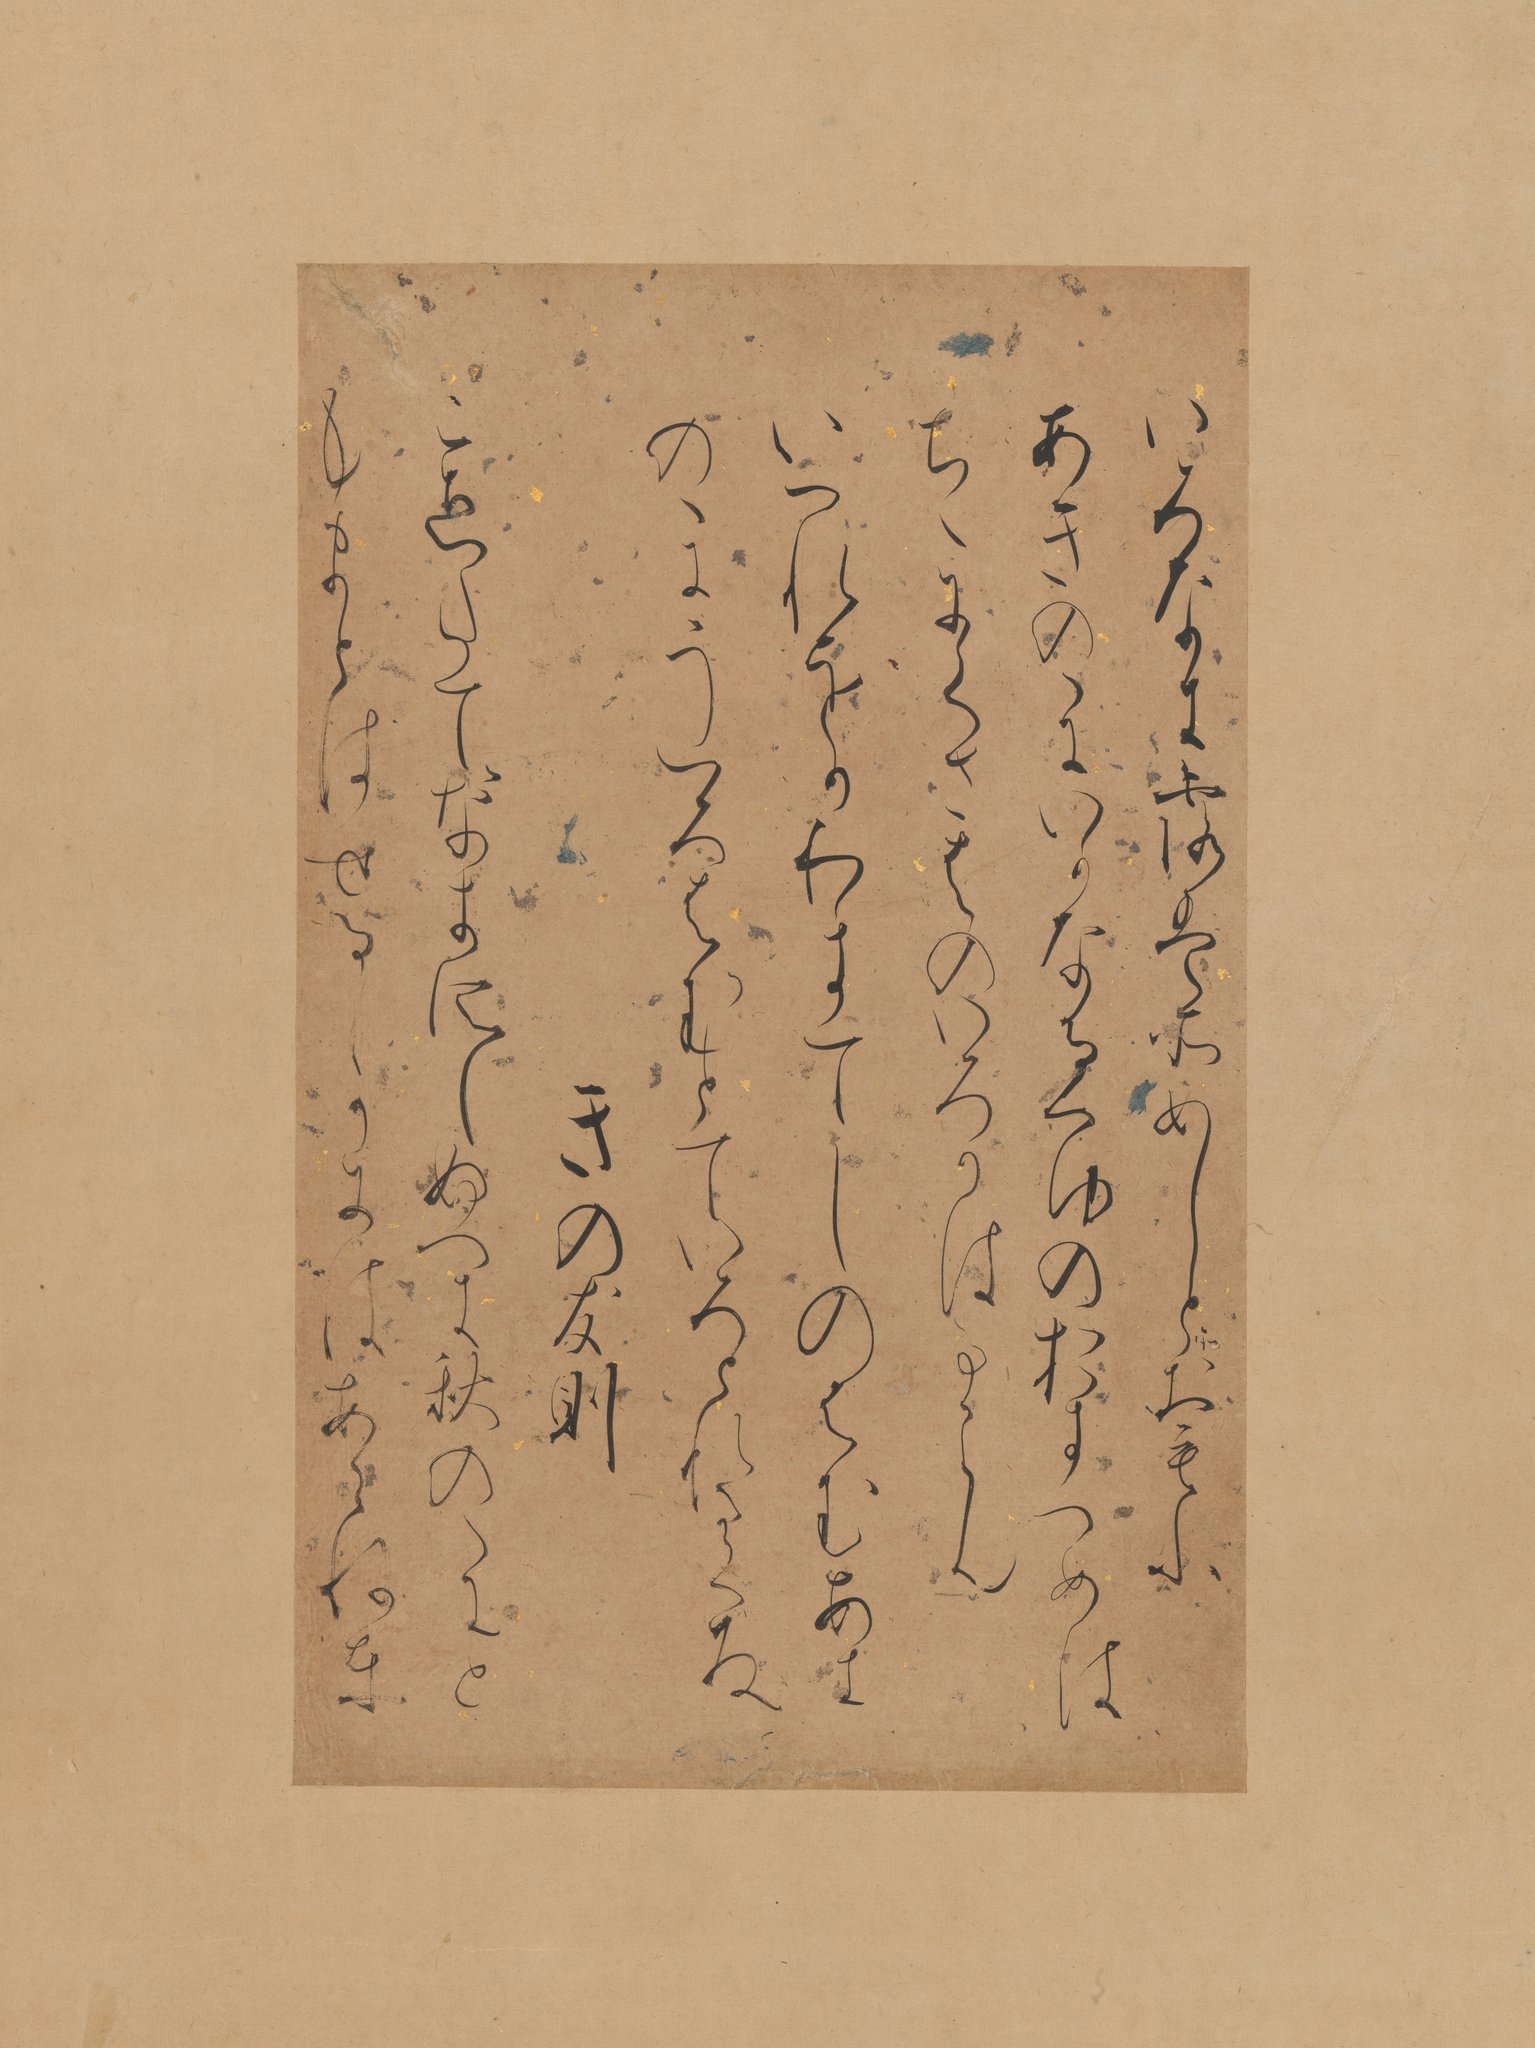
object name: hanging scroll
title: Three poems from the “Later Collection of Japanese Poems” (Gosen wakashū), known as the “Karasumaru Fragment” (Karasumaru-gire)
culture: japanese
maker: fujiwara no sadayori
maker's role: artist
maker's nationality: japanese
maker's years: 995-1045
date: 1101-1133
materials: ink, paper